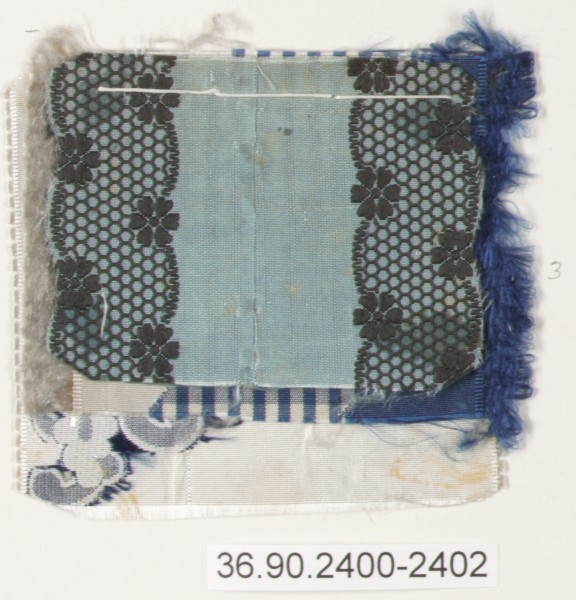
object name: ribbon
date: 1801-1900